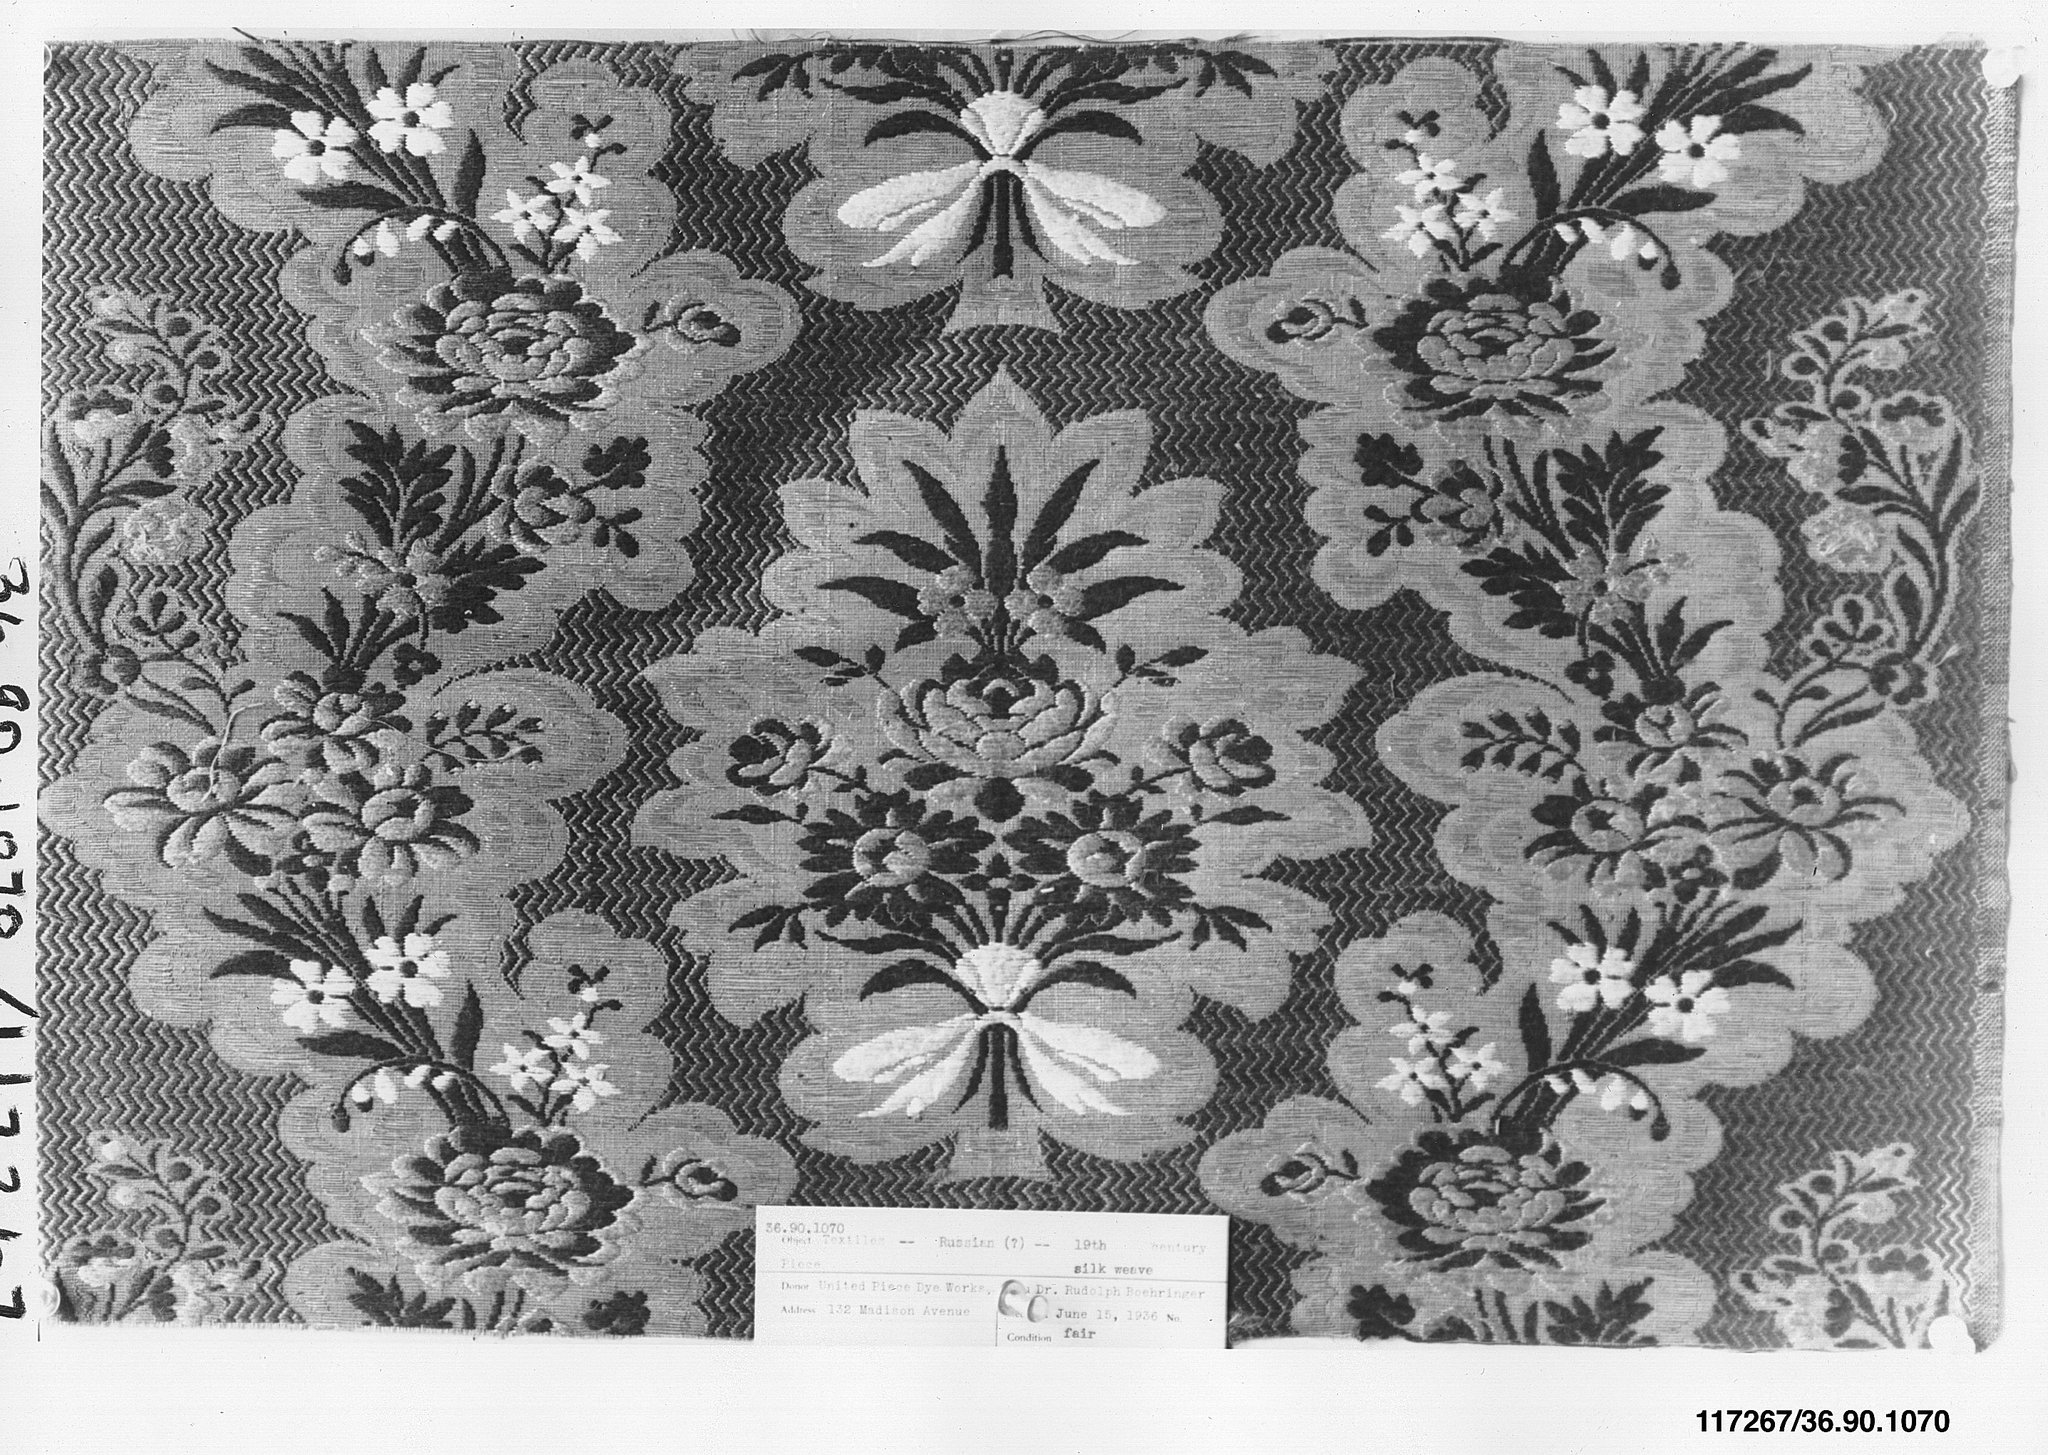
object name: piece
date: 1801-1900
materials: metal thread, silk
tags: flowers,leaves